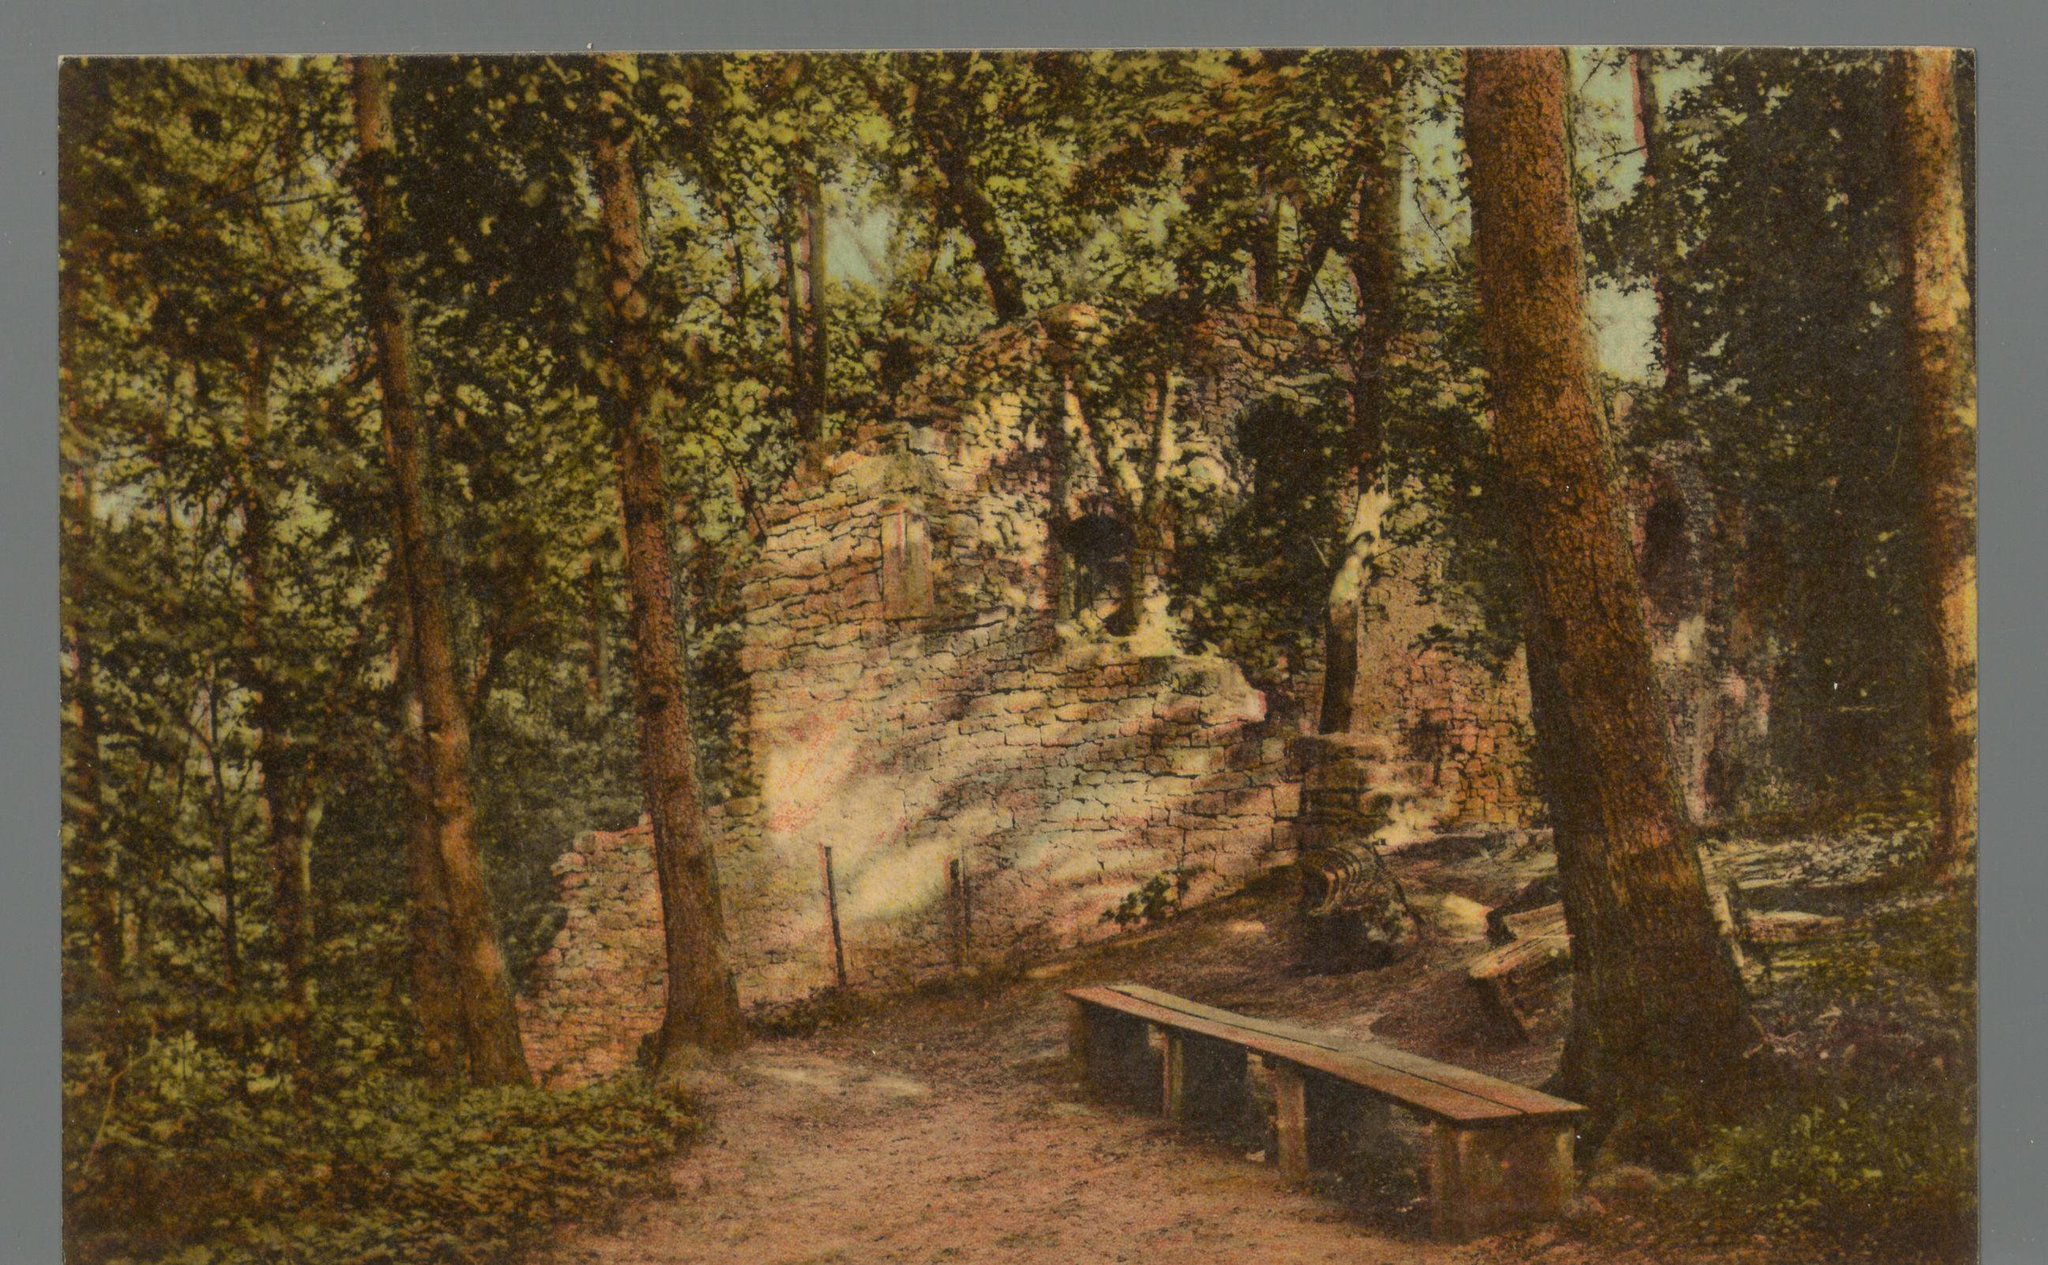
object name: ansichtkaart, prentbriefkaart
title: Weimar. Partie an der alten Ruine im Park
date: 1905-1930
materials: cardboard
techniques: photograph, lithograph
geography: hamburg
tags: park, ruin of a dwelling, house, castle, etc.